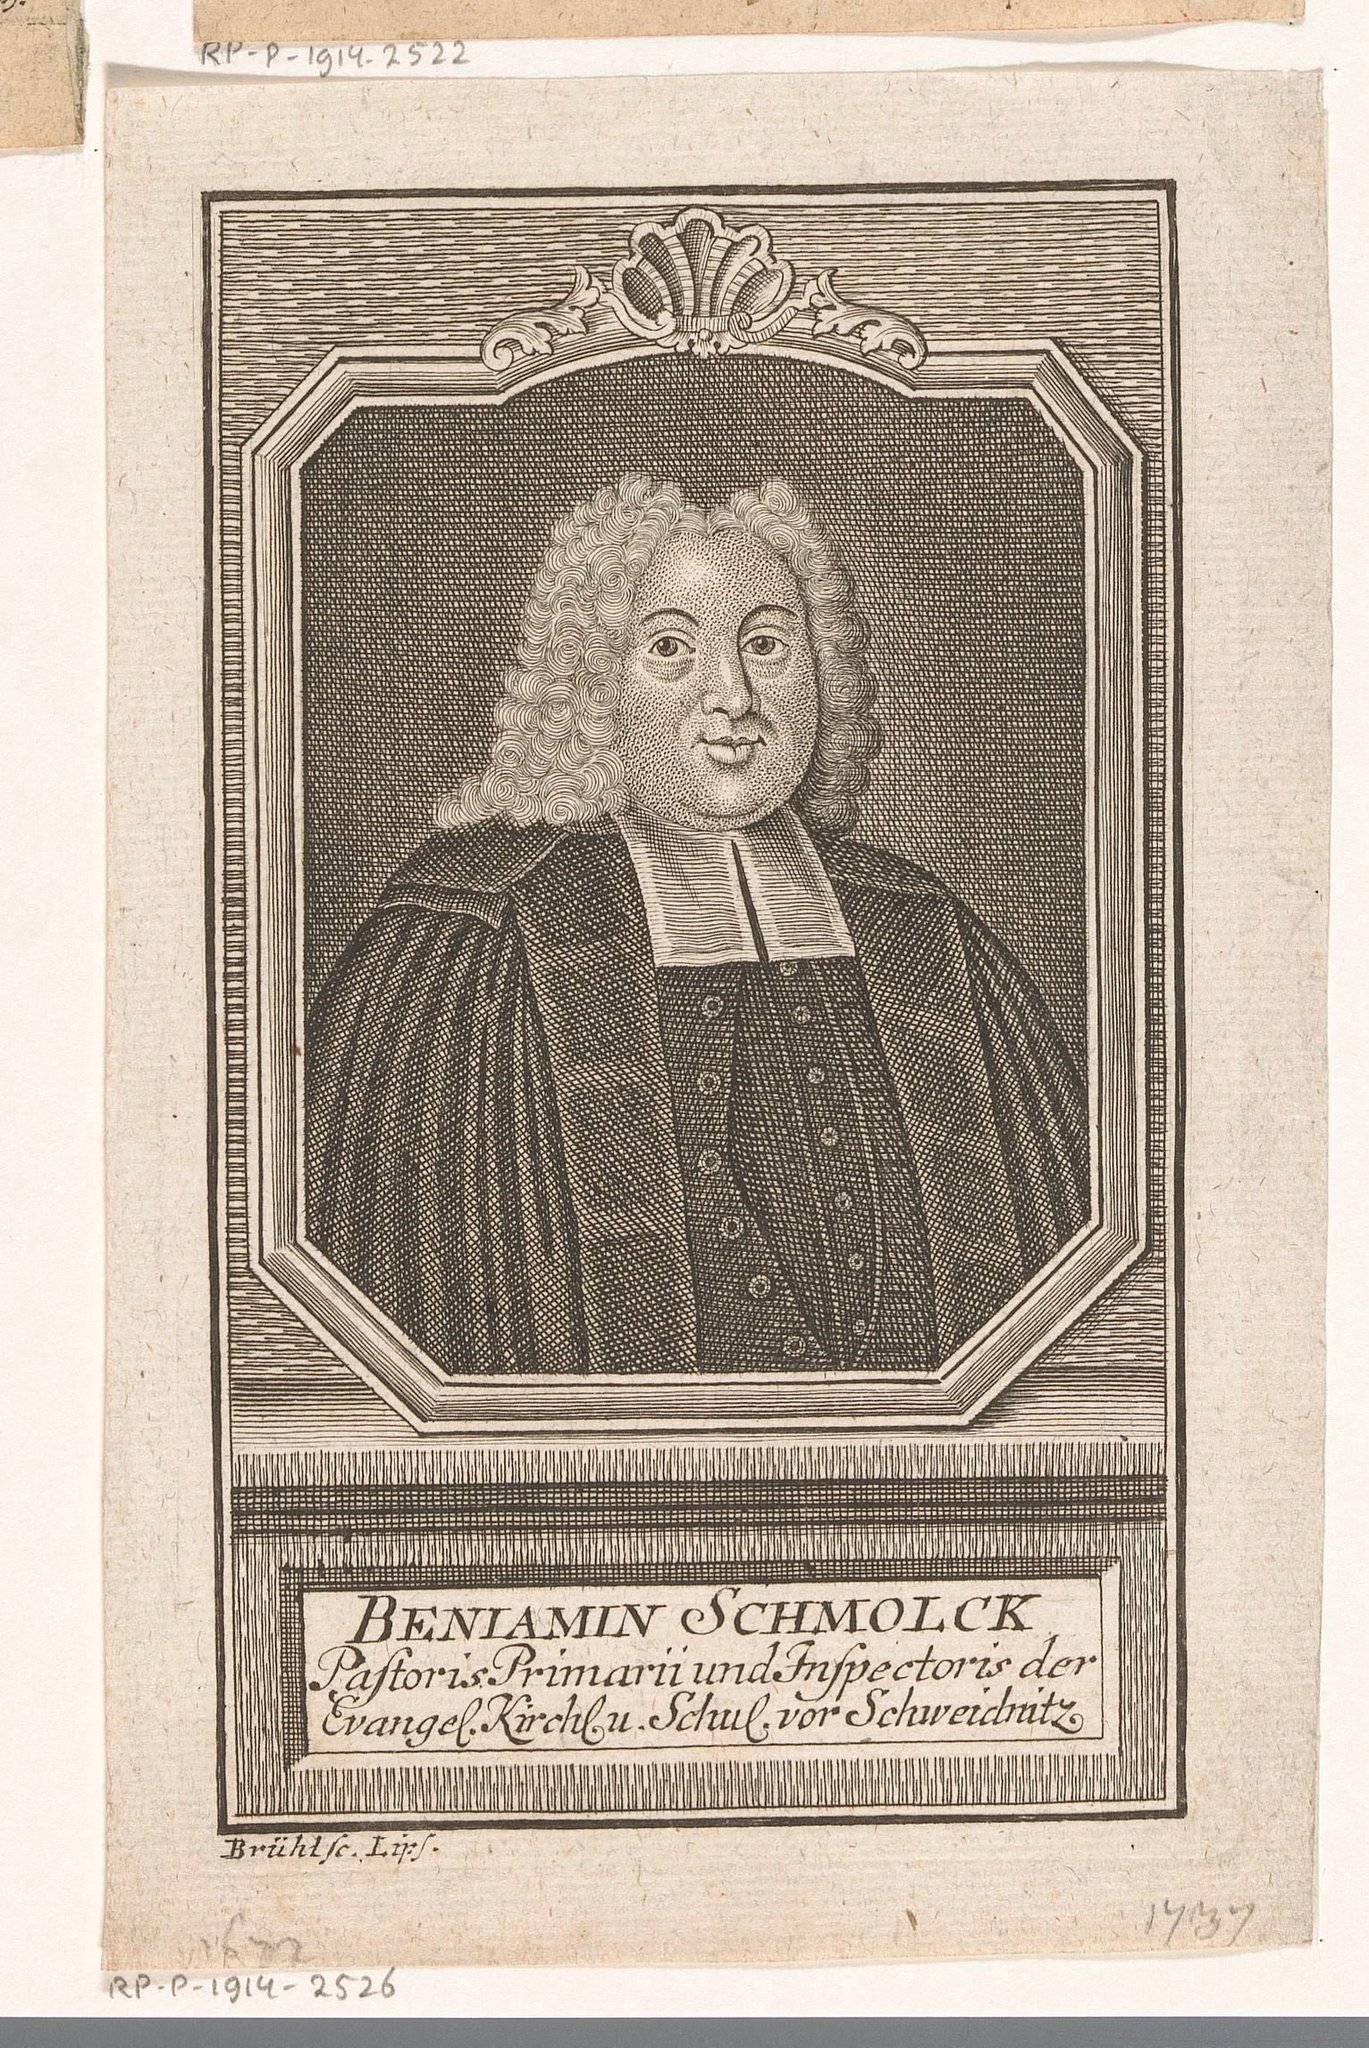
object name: print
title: Portret van Benjamin Schmolck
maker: johann benjamin brühl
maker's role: print maker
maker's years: 1691-1763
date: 1714-1763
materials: paper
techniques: engraving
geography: leipzig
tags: historical persons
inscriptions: collector's mark: Lugt 2228